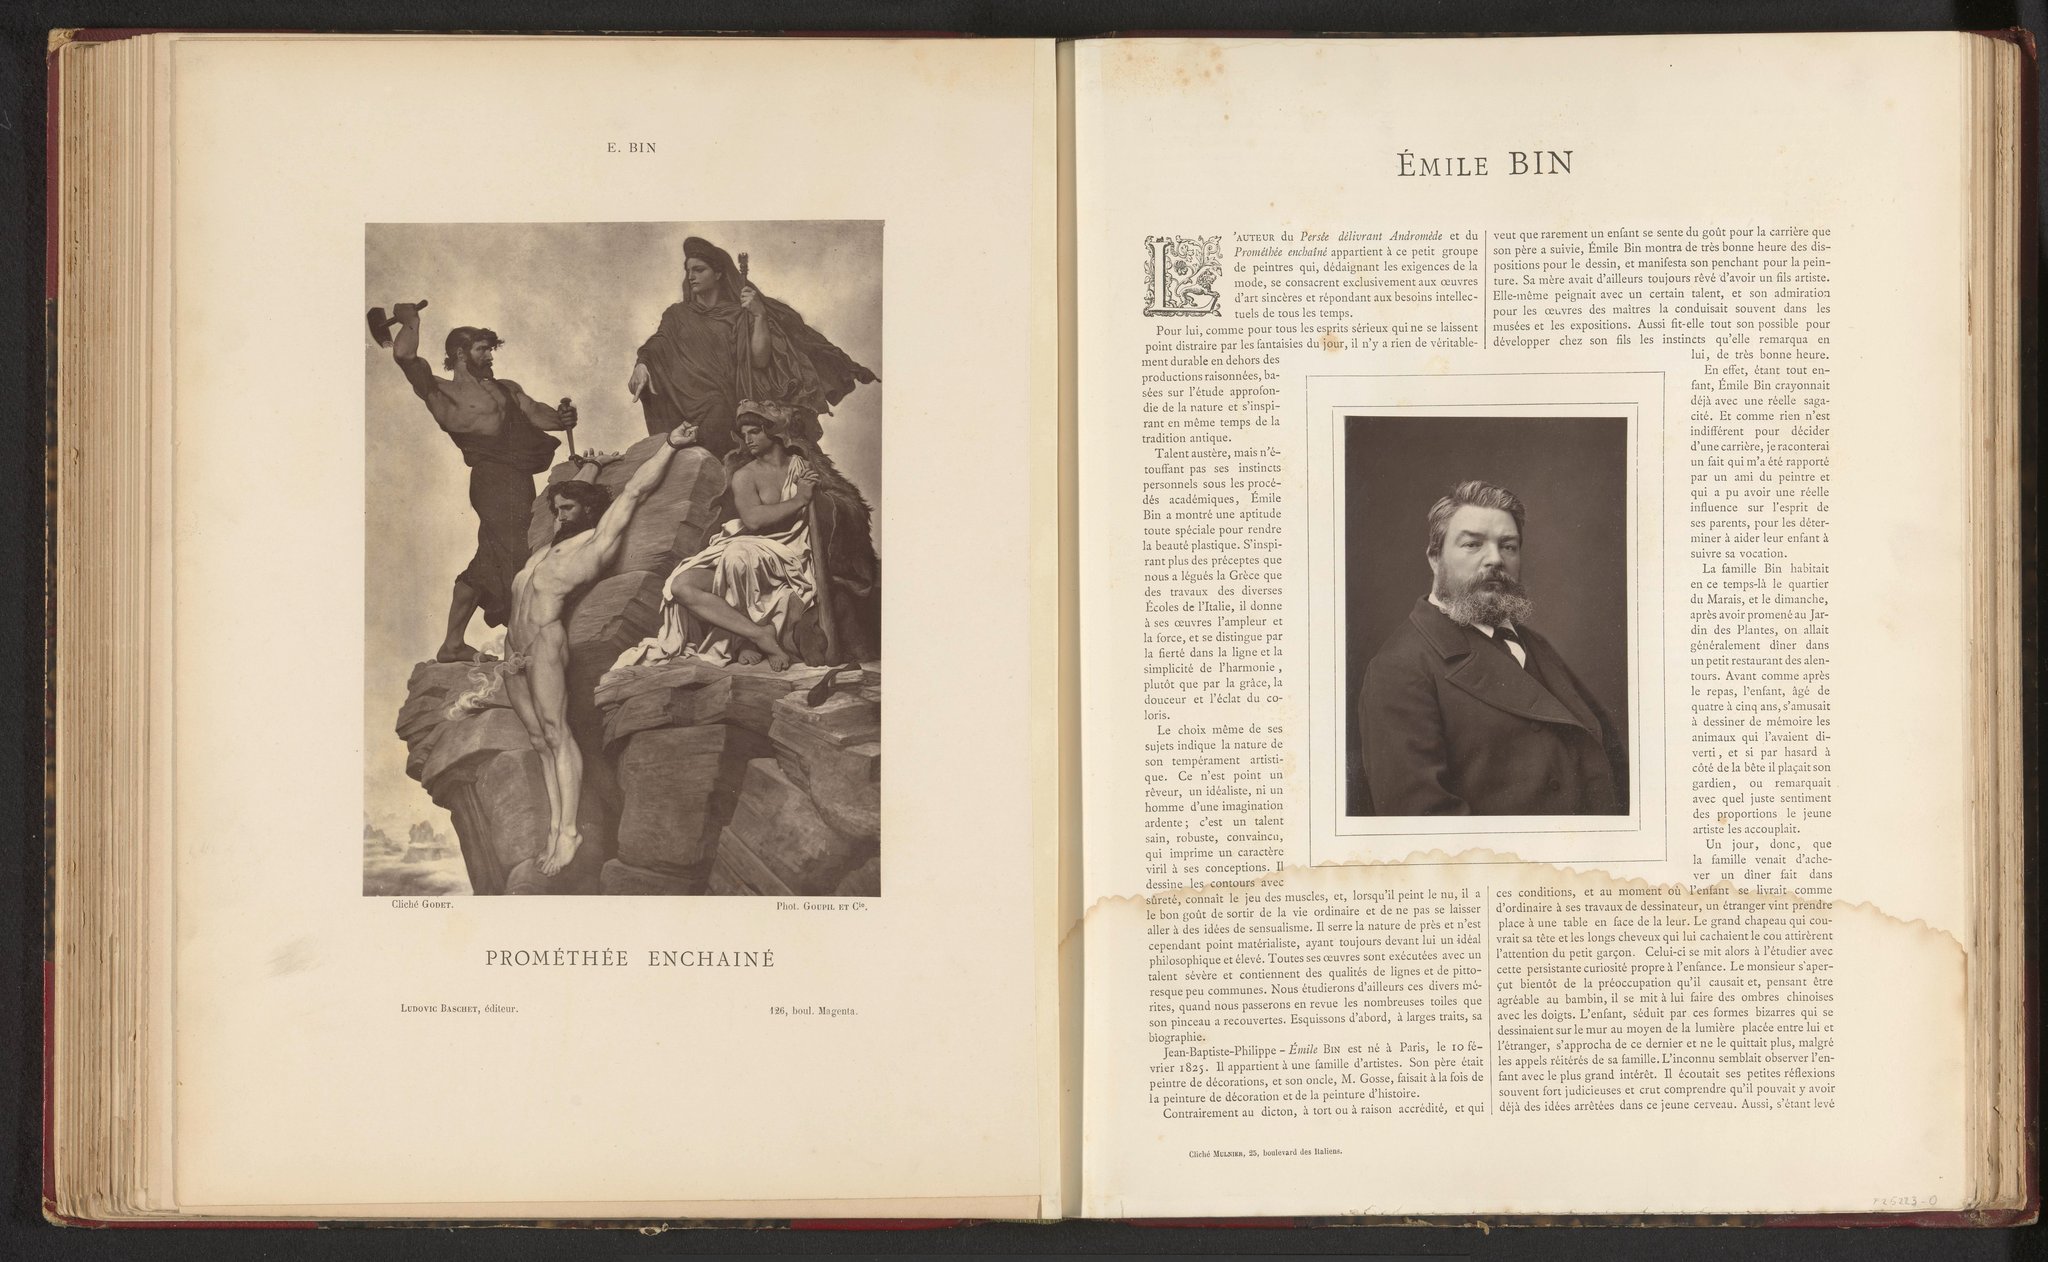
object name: page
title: Portret van Émile Bin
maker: ferdinand mulnier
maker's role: painter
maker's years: 1817-1891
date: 1876-1879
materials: paper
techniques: woodburytype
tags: émile bin, portrait, self-portrait of painter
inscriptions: inscription: ‘25, boulevard des Italiens.’